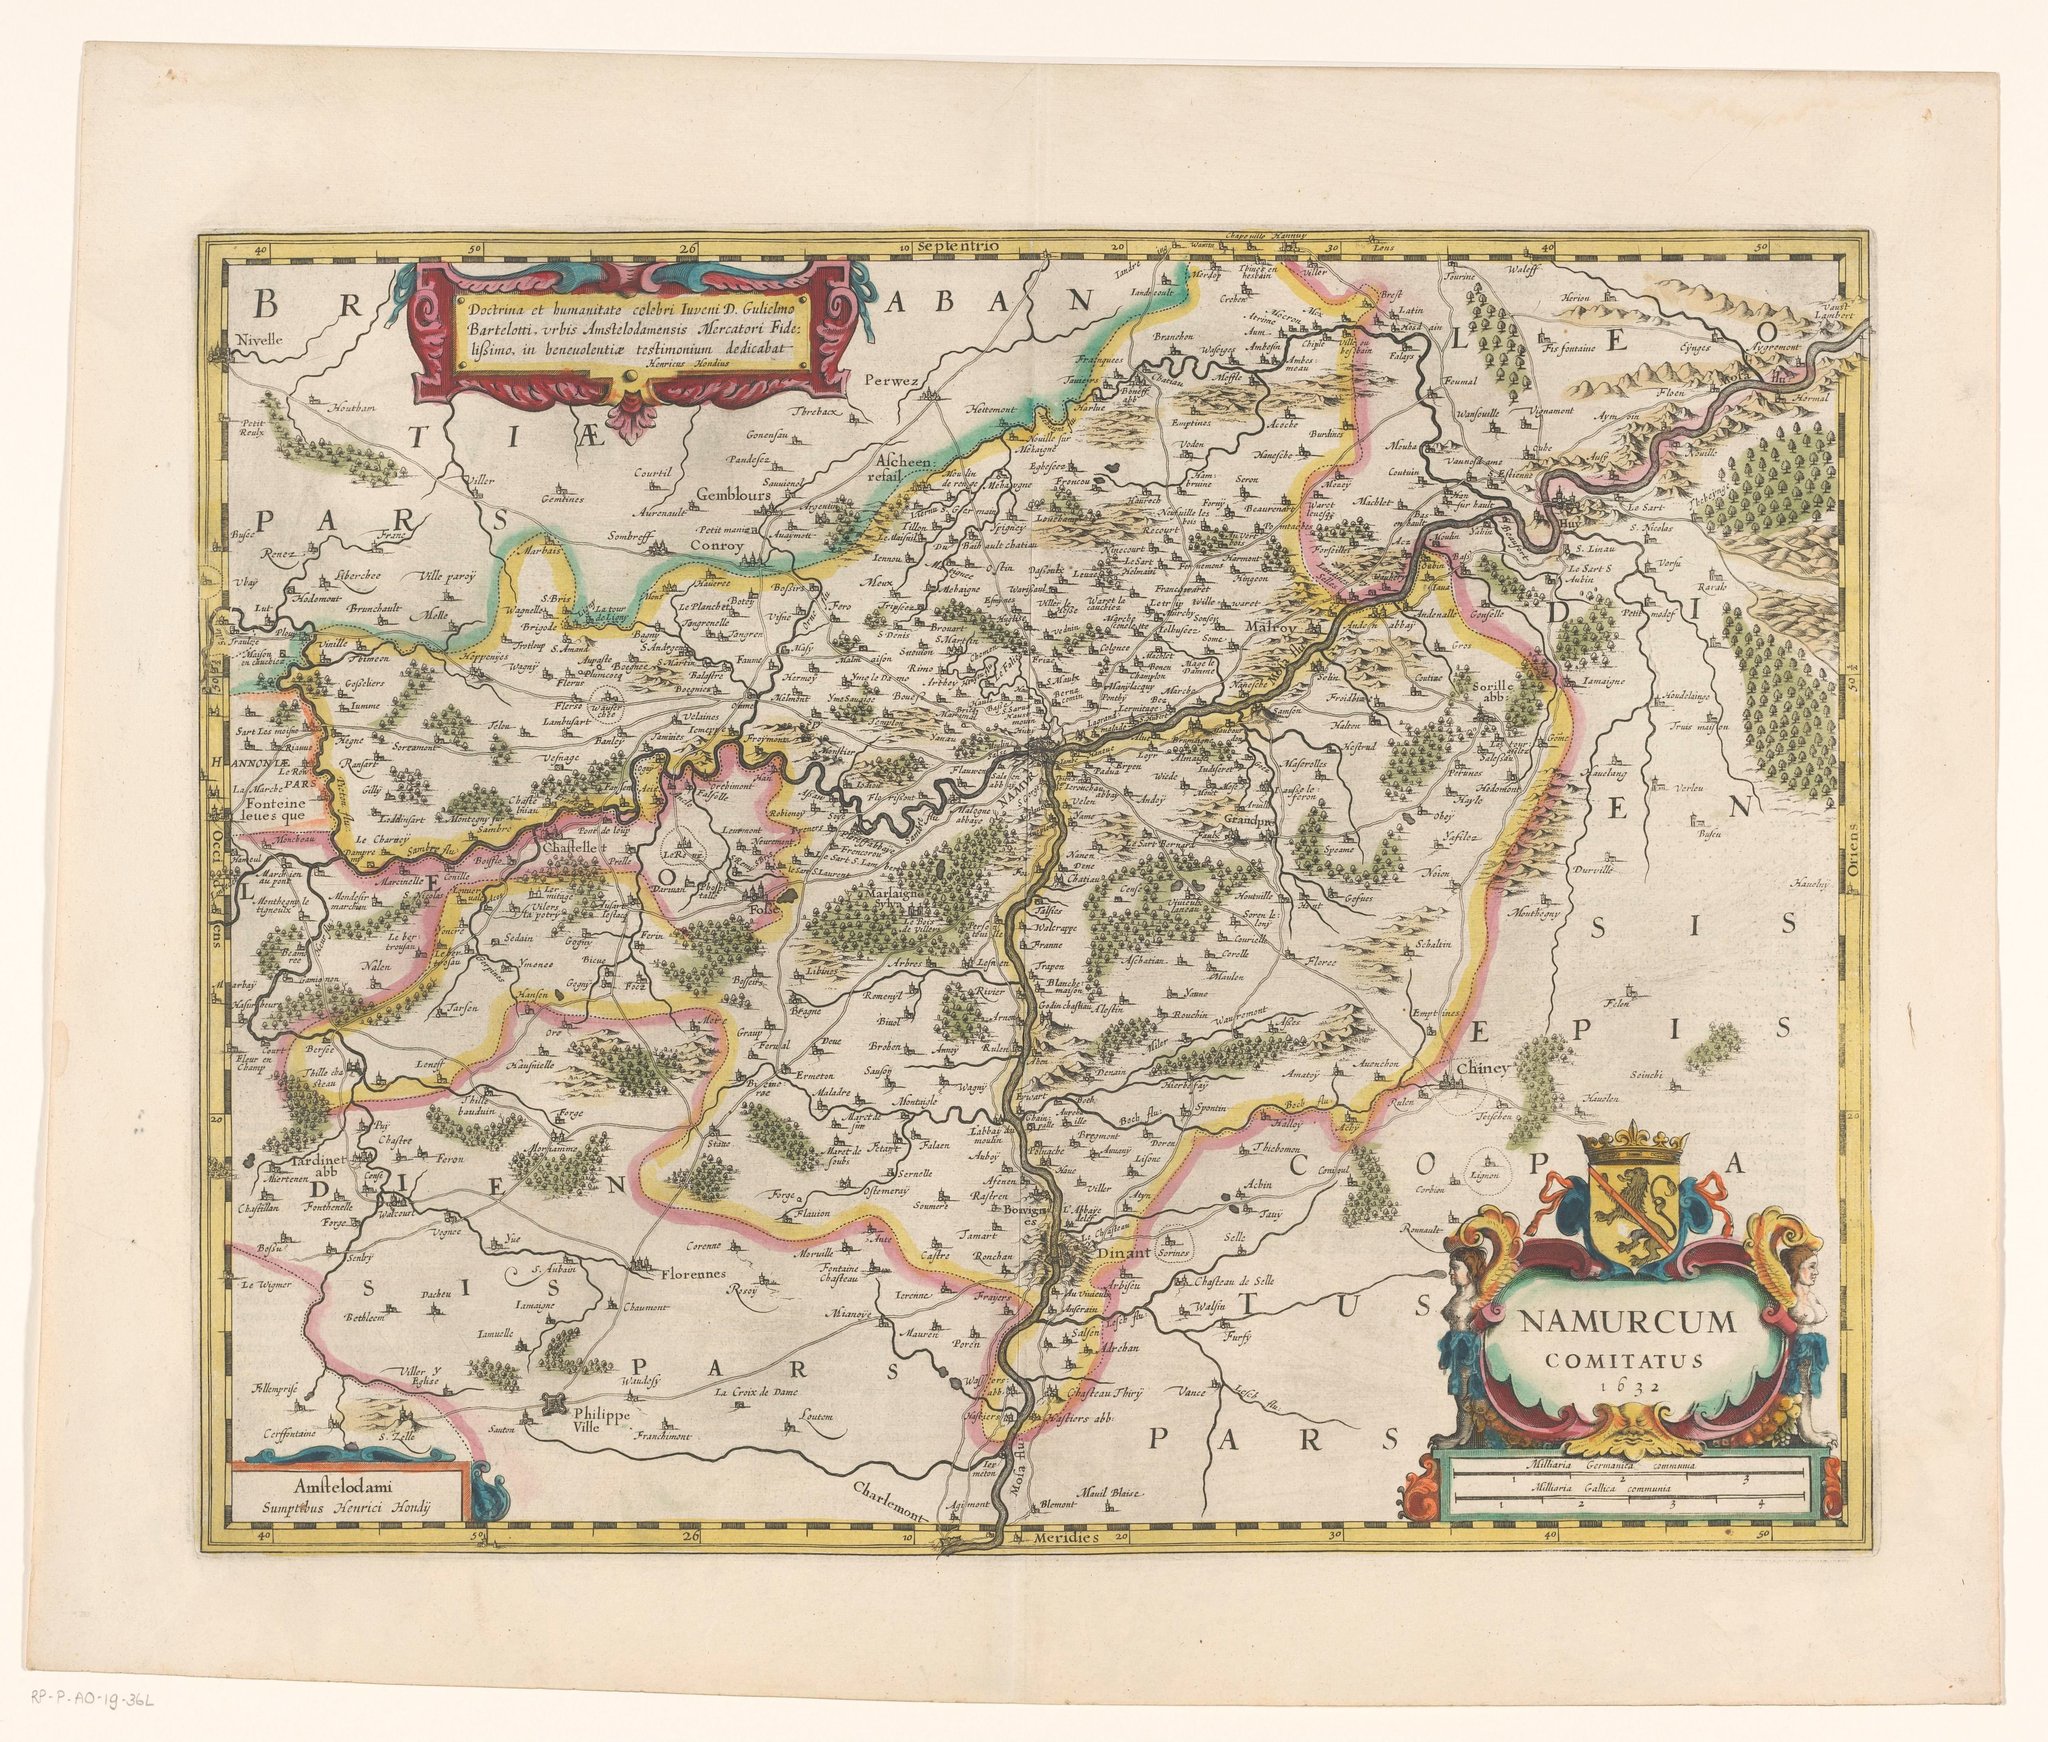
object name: print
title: Kaart van het graafschap Namen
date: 1633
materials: paper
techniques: engraving, hand coloring, letterpress printing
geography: amsterdam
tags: maps of separate countries or regions, coat of arms (as symbol of the state, etc.) (+ province; provincial)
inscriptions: collector's mark: Lugt 2228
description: Prent gebruikt in: Mercator, Gerard en Jodocus Hondius. Atlas ou representation du monde universel, et des parties d’icelui (…). 2 delen. Amsterdam: Henricus Hondius, 1633, dl. 1. Of in: Mercator, Gerard en Jodocus Hondius. L'appendice de l'atlas de Gerard Mercator et Iudocus Hondius: contenant diverses nouvelles tables et descriptions (…). Amsterdam: Henricus Hondius, 1633.